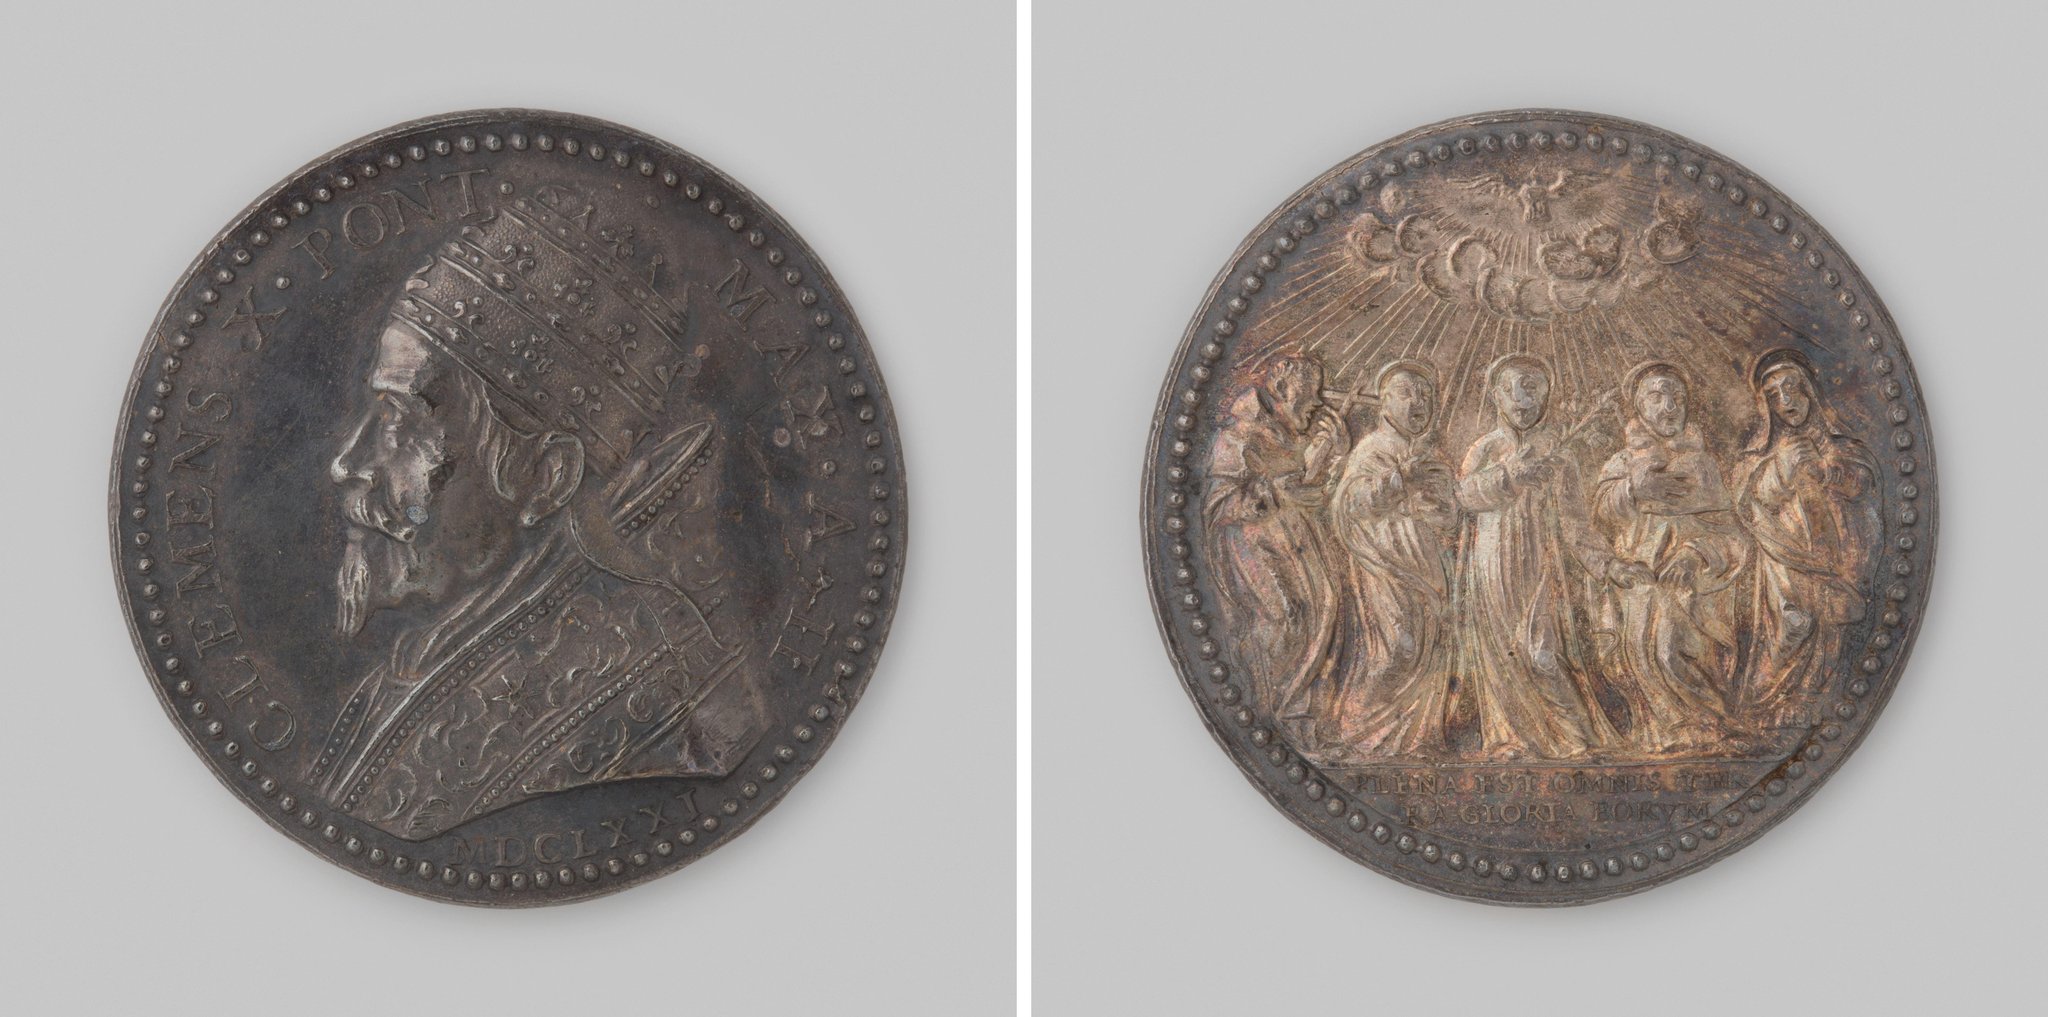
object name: history medal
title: Paus Clemens X 1671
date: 1671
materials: silver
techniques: striking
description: Zilveren penning, op de voorzijde het portret van Clemens naar links met tiara, met omschrift, op de keerzijde vijf heiligen in het licht van de Heilige Geest, met afsnedetekst.